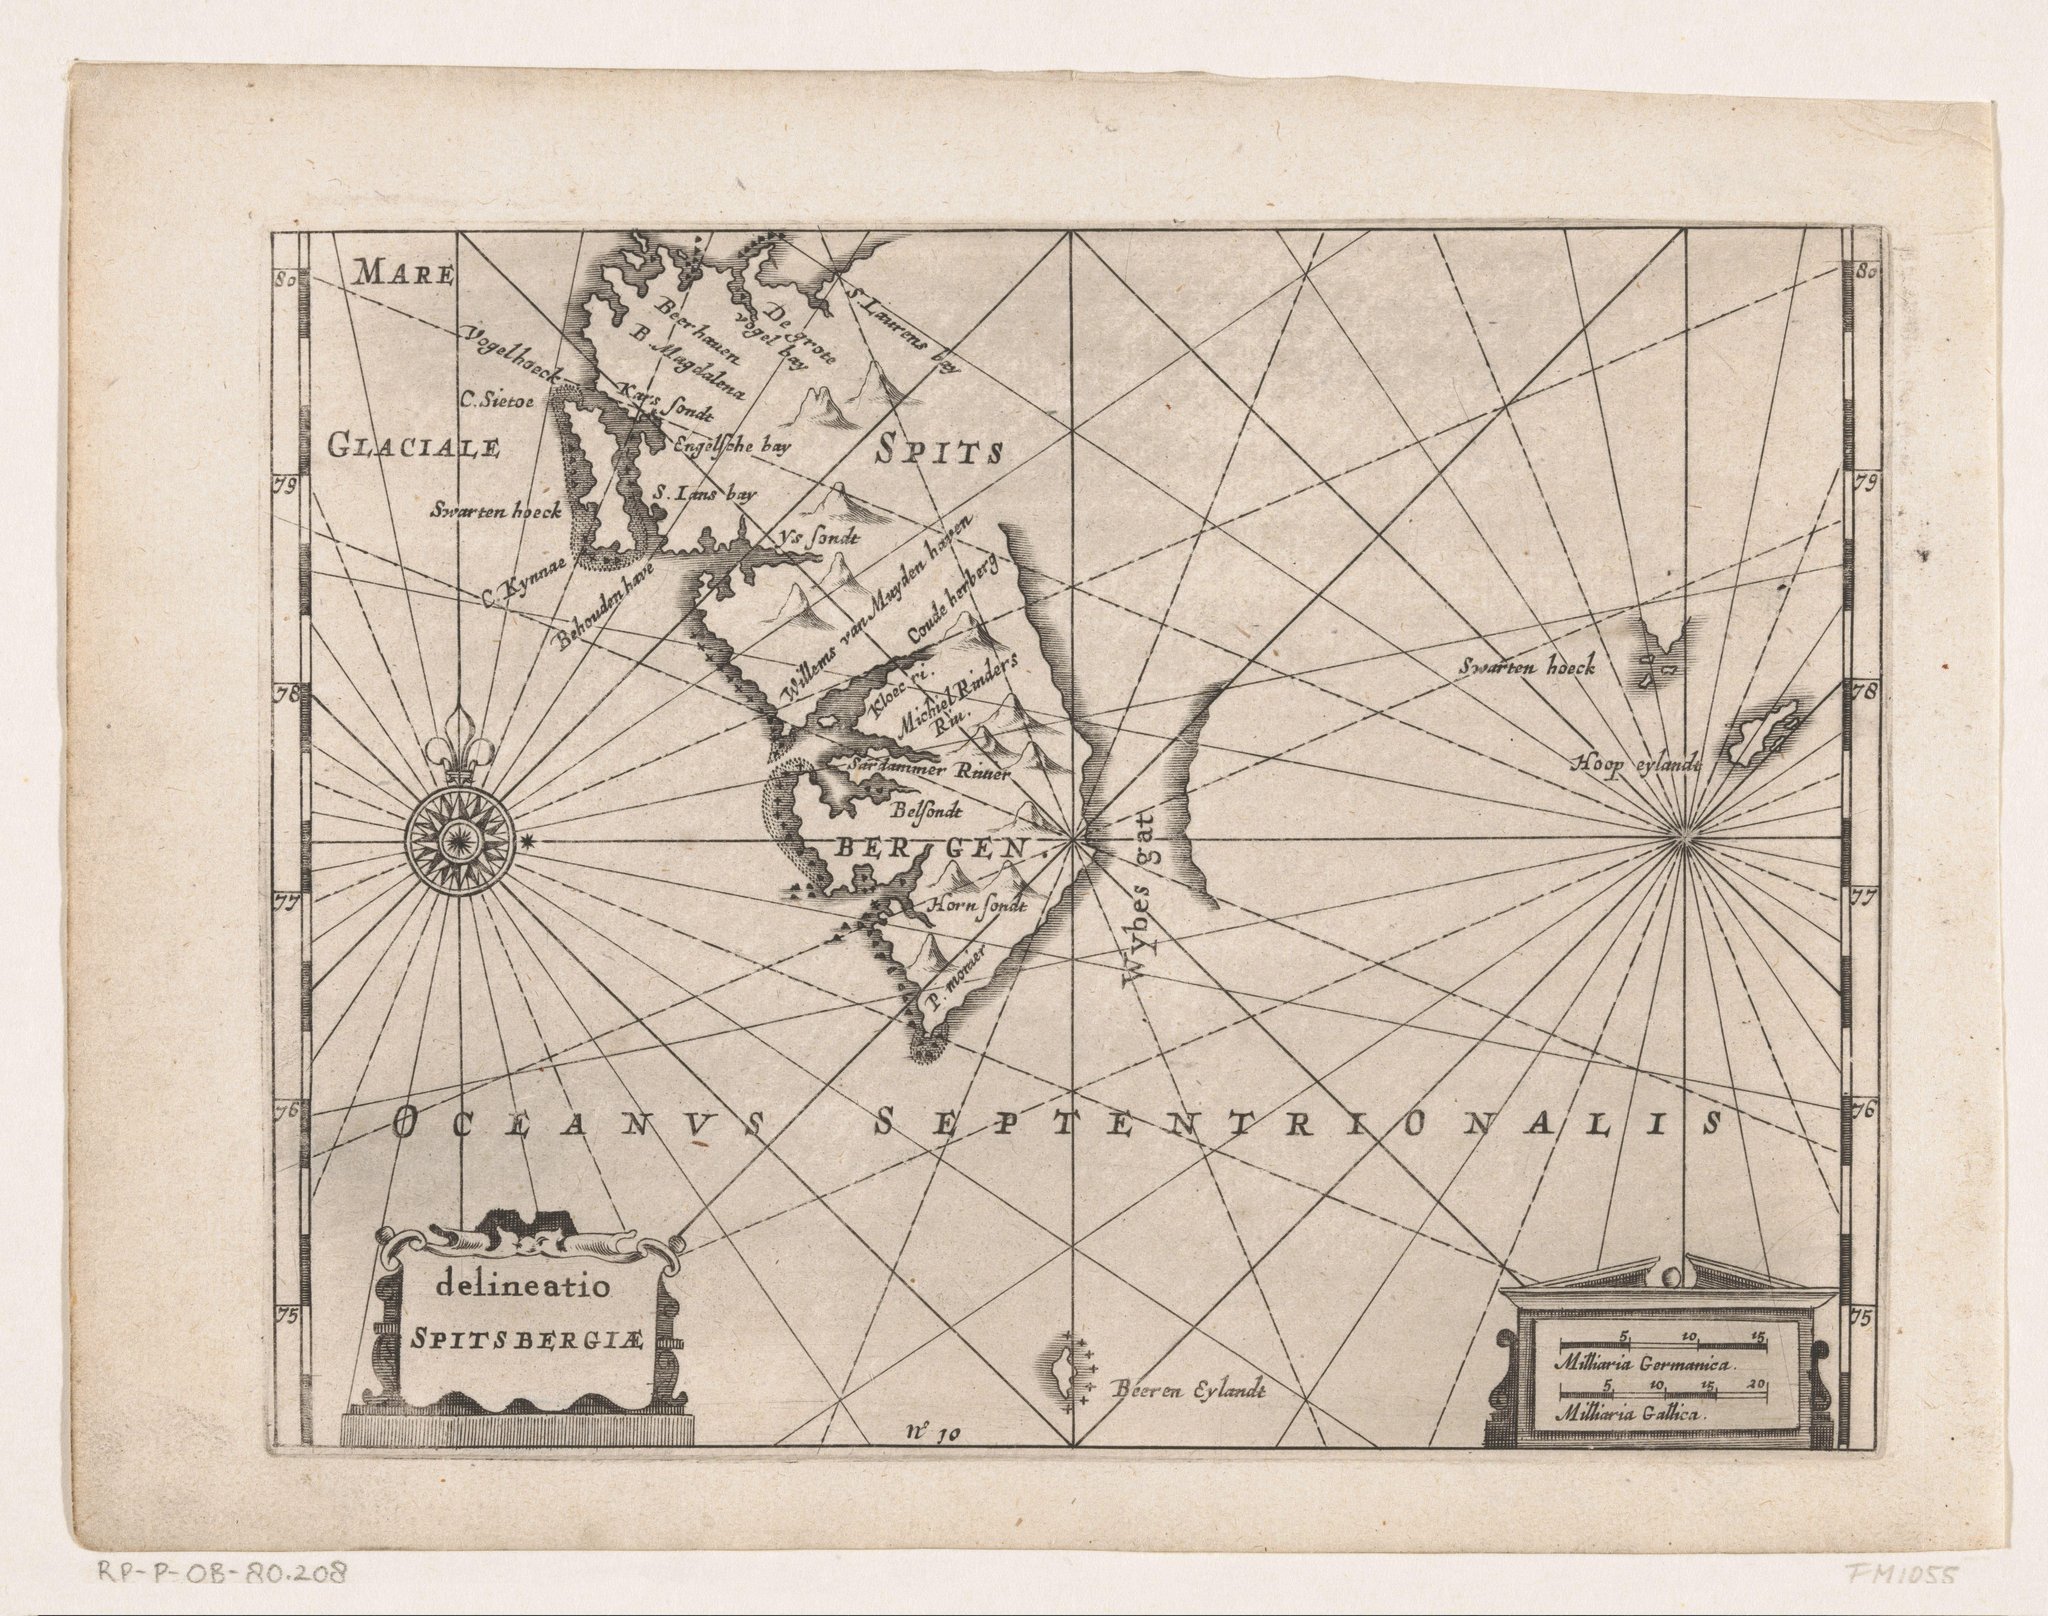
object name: history print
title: delineatio Spitsbergiae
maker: Anonymous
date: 1644-1646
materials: paper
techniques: engraving, etching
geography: northern netherlands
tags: willem barendsz., amsterdam, jacob van heemskerck, maps of separate countries or regions, landscapes in polar regions, exploration, expedition, voyage of discovery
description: Ontbreekt in: G. de Veer, De waerachtige beschrijvinge vande drie seylagien, drie jaren achter mal-kanderen deur de Hollandtsche ende Zeelandtsche Schepen, by noorden Noorweghen, Moscovien ende tartarien nae de Coninckrijcken van Catthay ende China ghedaene, [Michiel Colijn, Amsterdam 1617]. Eerst gebruikt in: Kort verhael van d'eerste Schipvaerd der Hollandsche ende Zeeusche Schepen by noorden Noorwegen, Moscovien ende Tartarien om, nae de Coningrijcken van Cathay ende China, getogen uyt het Journael van Gerrit de Veer. Opgenomen in: I. Commelin, Begin ende voortgangh, van de Vereenighde Nederlantsche Geoctroyeerde Oost-Indische Compagnie, J. Janssonius, Amsterdam 1646. Genummerd: No. 10.